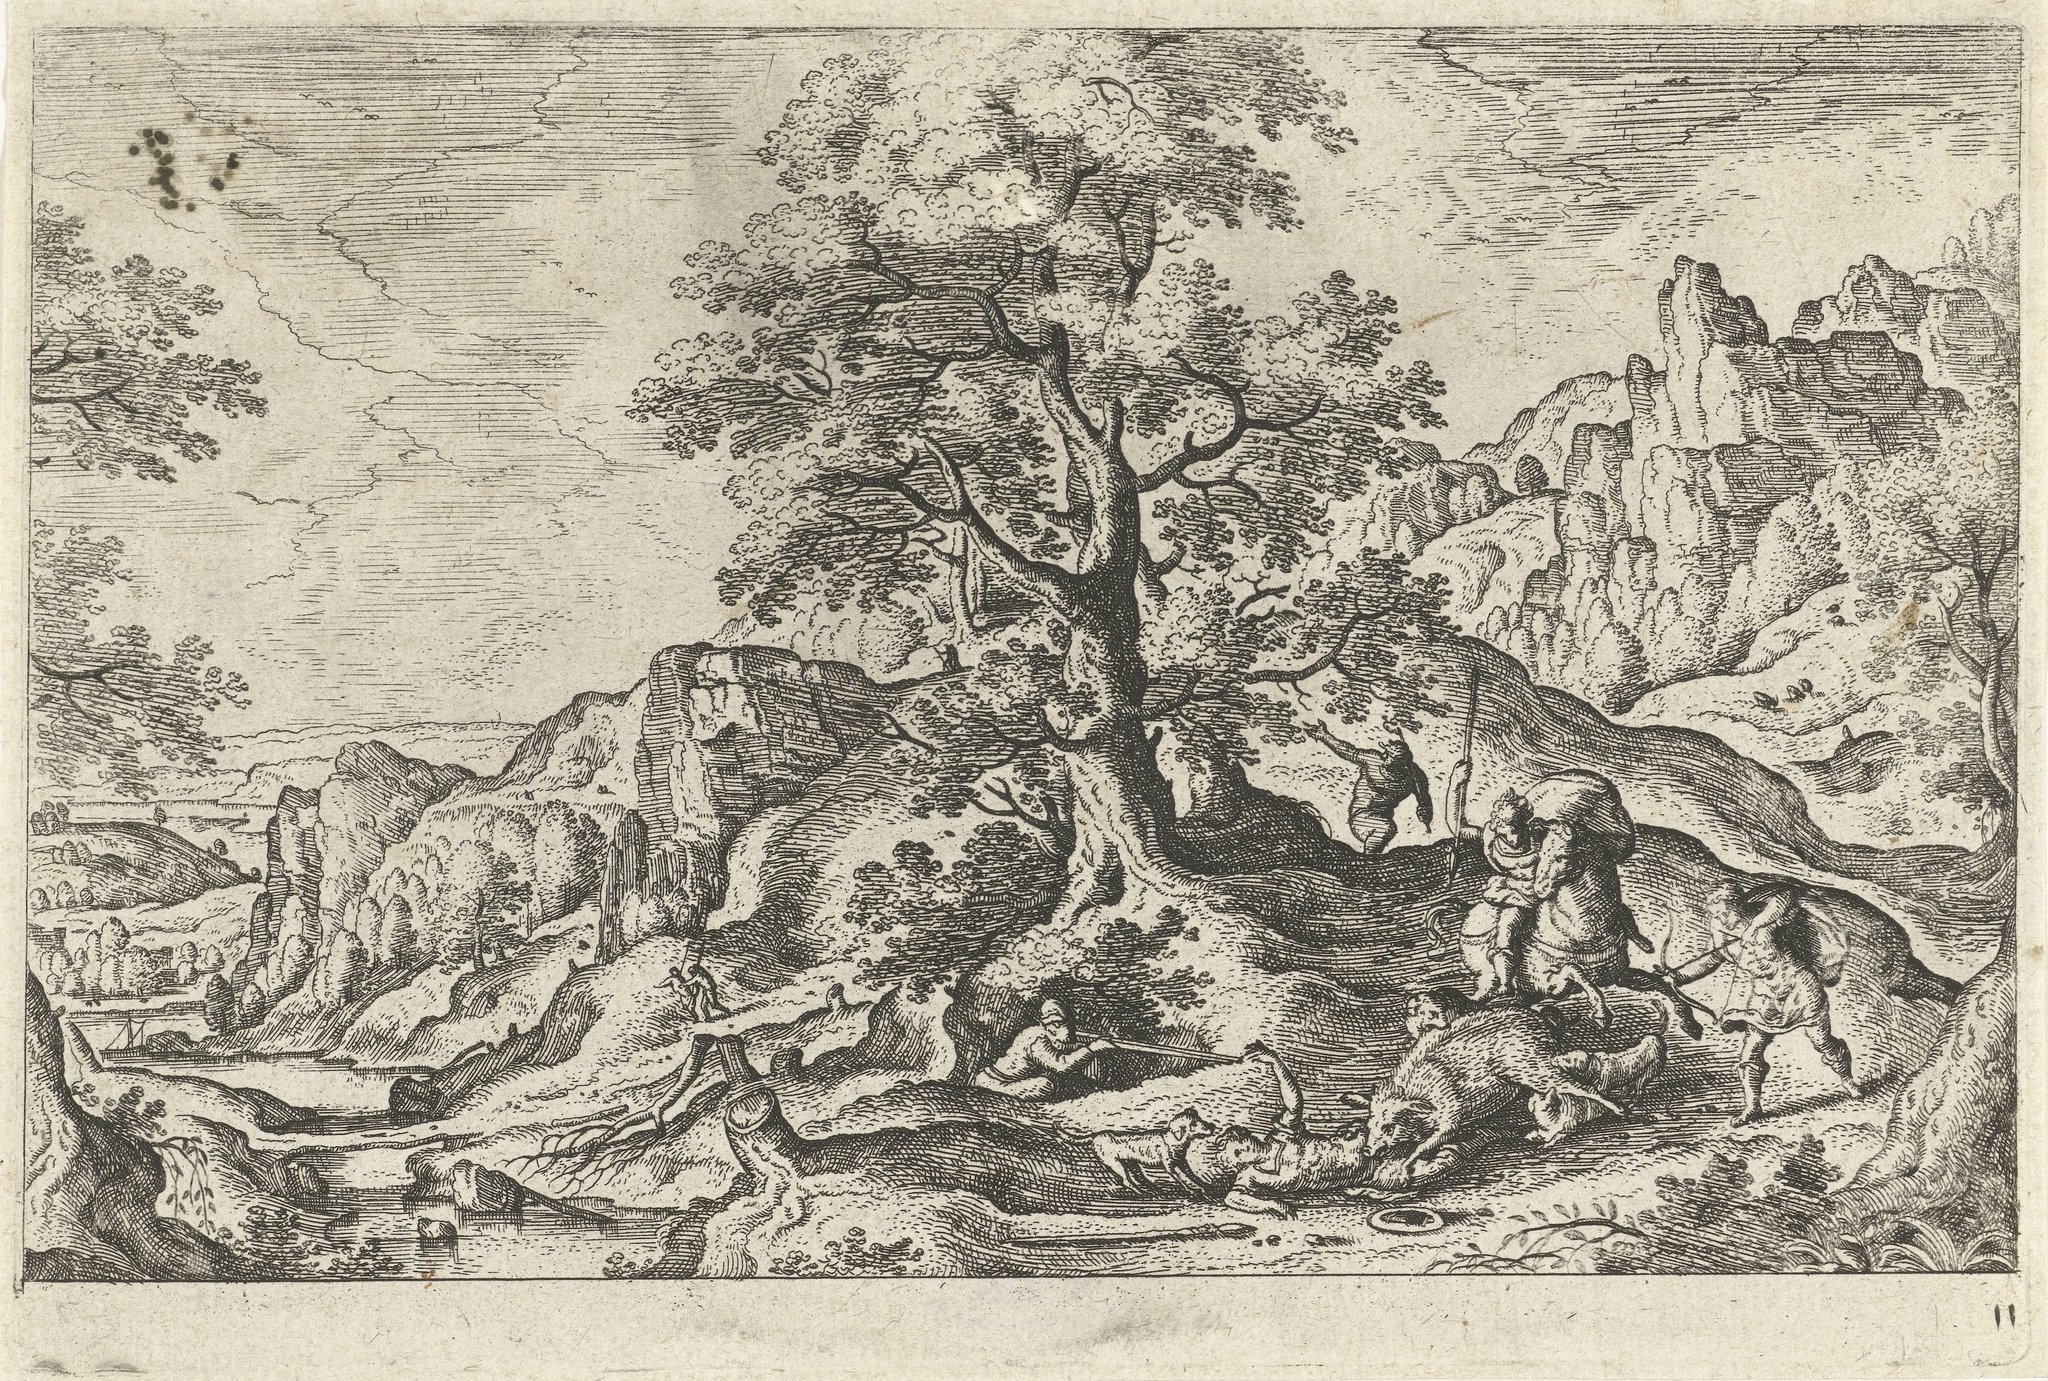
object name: print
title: Meleager doodt het wilde zwijn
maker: Anonymous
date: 1550-1650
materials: paper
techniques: etching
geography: southern netherlands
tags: the wild boar is killed, usually by meleager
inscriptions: collector's mark: Lugt 2228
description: Serie van 30 genummerde prenten. Volgorde blijft onduidelijk, omdat de nummering van verschillende staten (met of zonder onderschrift) afwijkt.